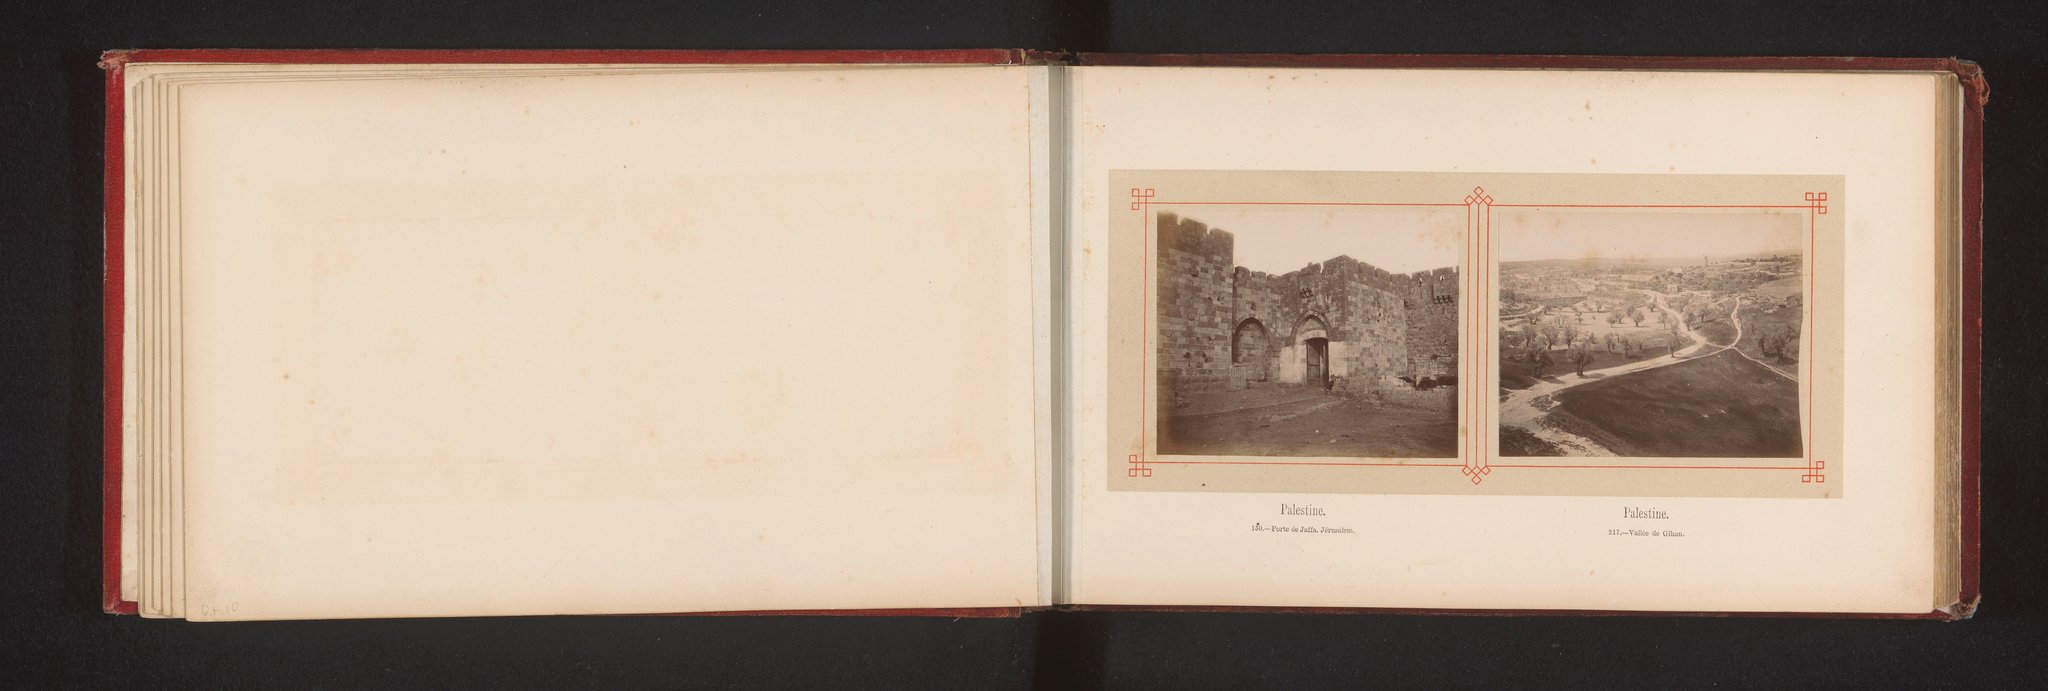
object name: photograph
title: Palestine - 217 - Vallée de Gihon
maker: félix bonfils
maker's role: fotograaf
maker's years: 1831-1885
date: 1873-1878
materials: photographic support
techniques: albumen print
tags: gate, entrance